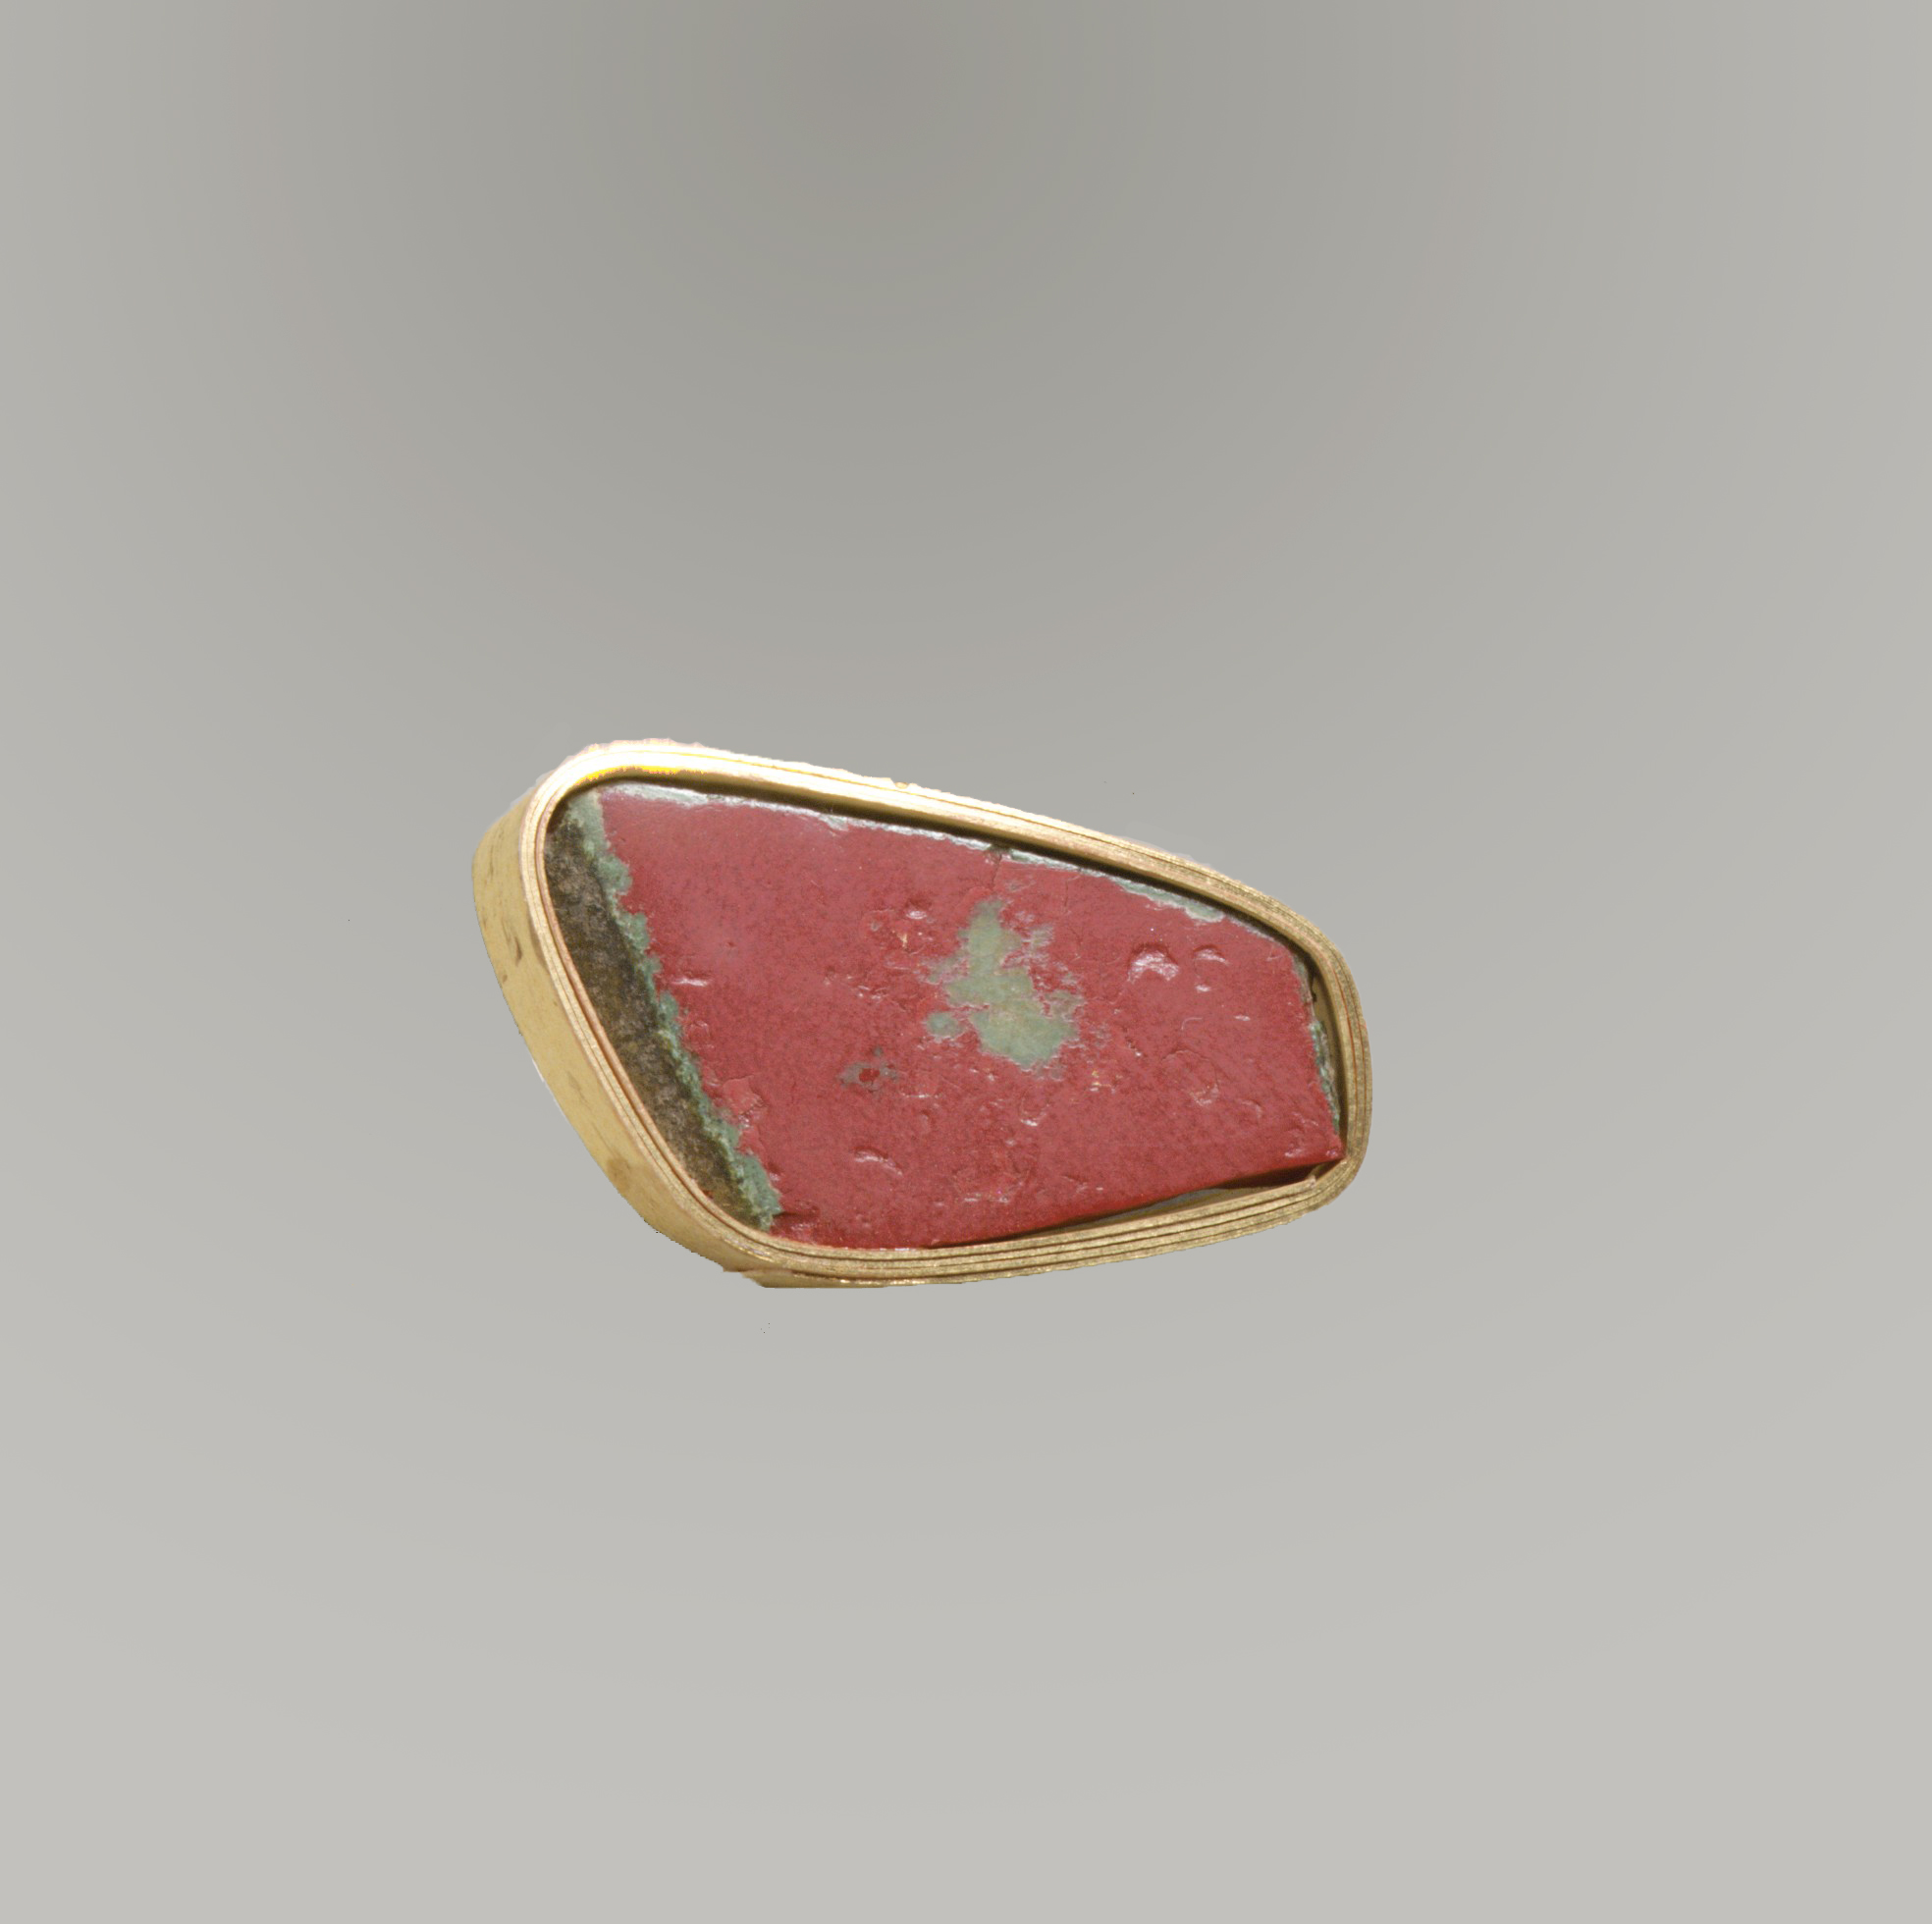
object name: fragment, monochrome, opaque red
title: Glass monochrome dish fragment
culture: roman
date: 1-50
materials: glass